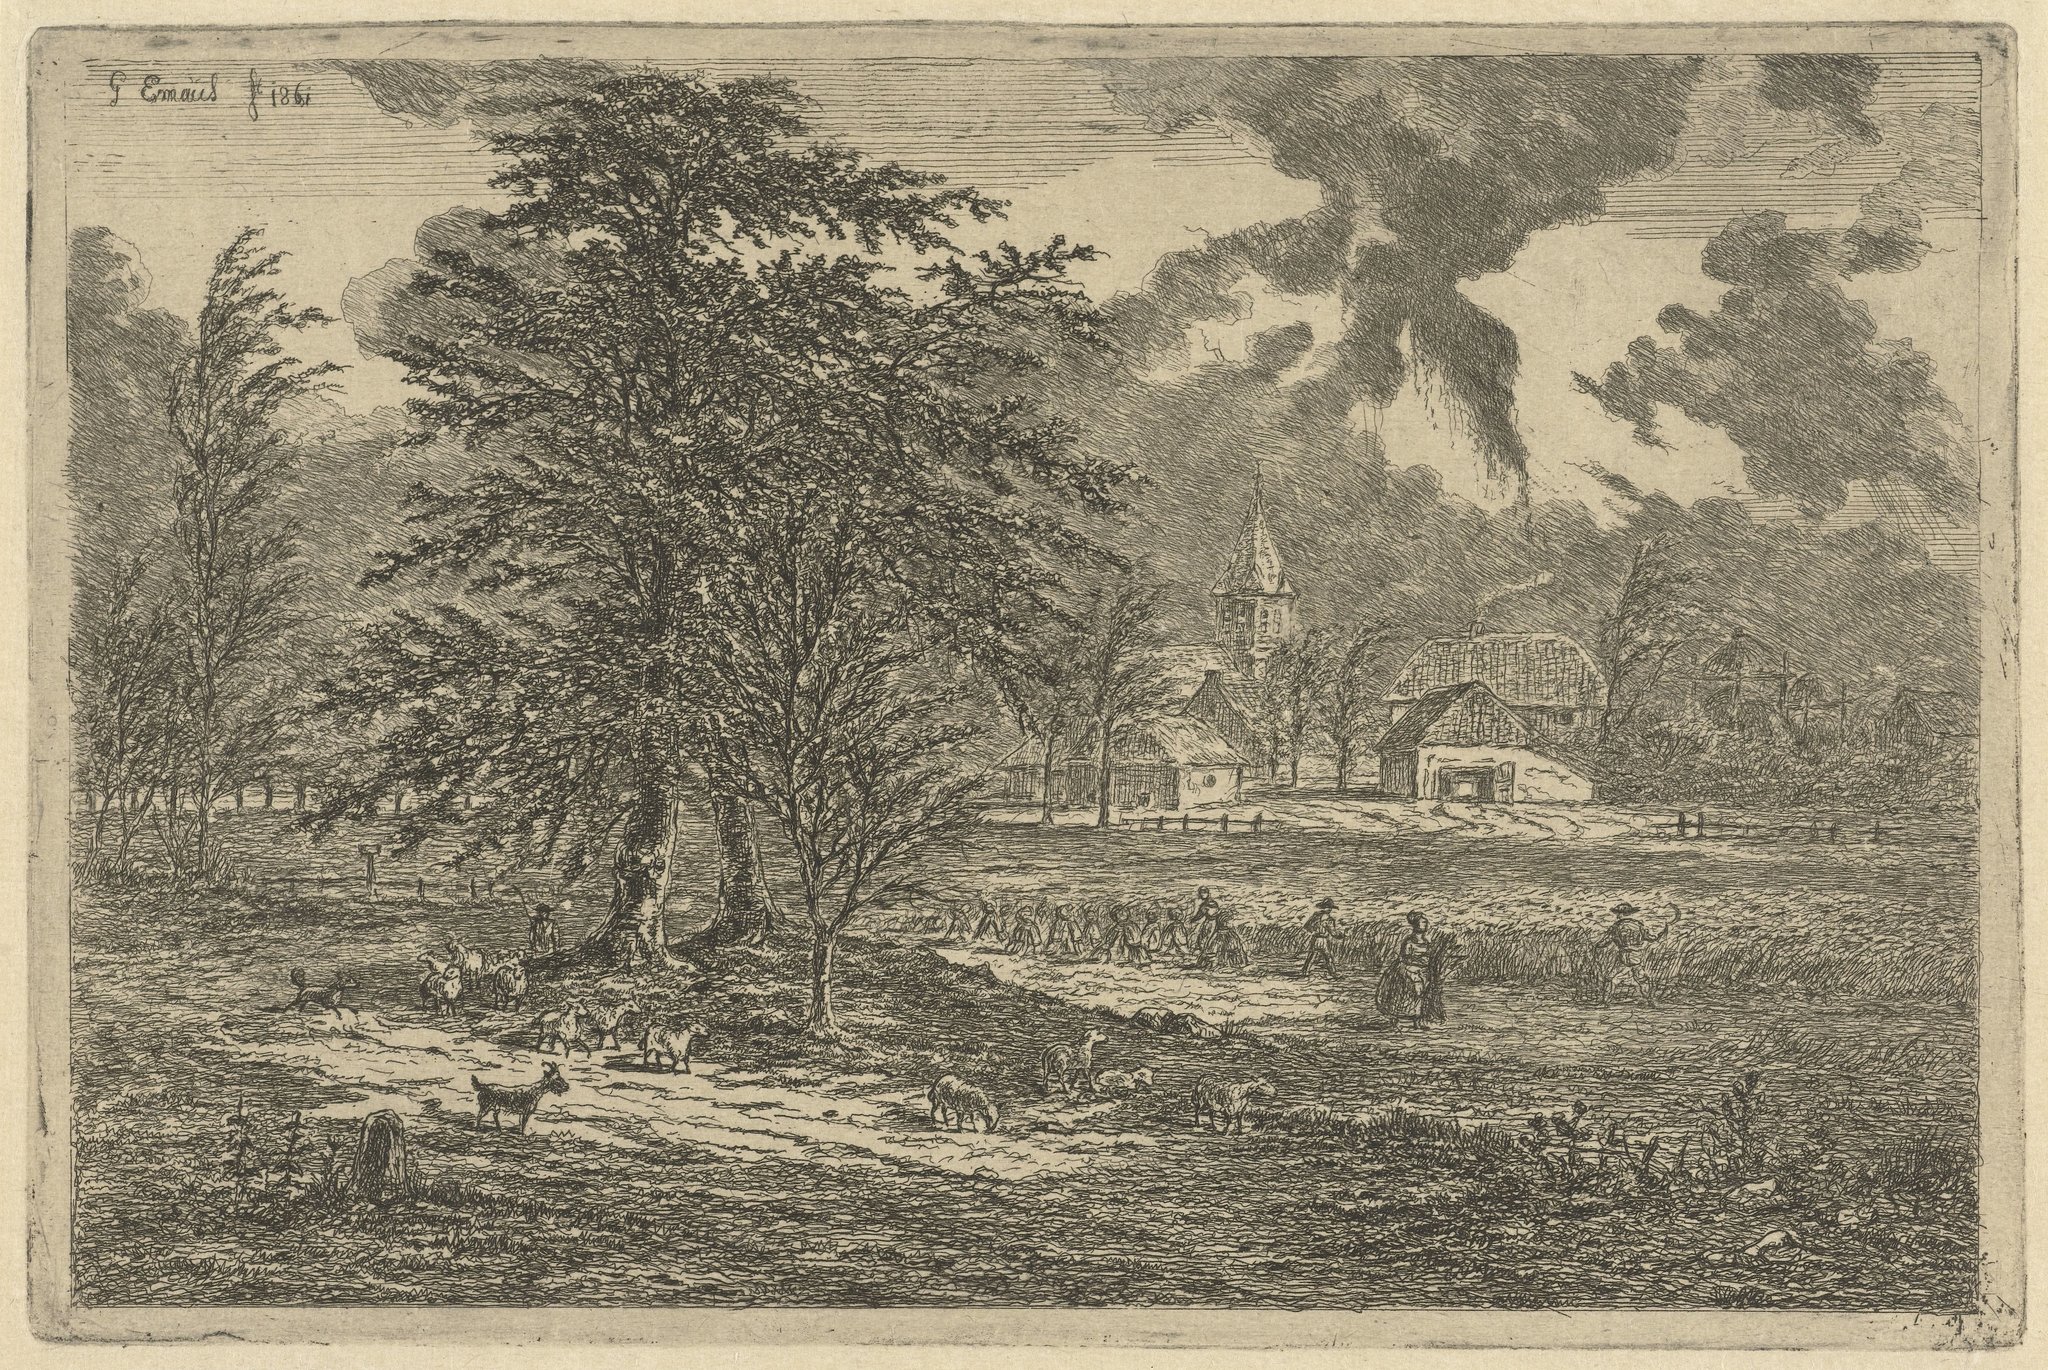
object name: print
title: Schaapsherder bij korenveld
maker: gerardus emaus de micault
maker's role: draughtsman, print maker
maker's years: 1798-1863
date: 1861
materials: paper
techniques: etching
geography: netherlands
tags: harvest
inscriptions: collector's mark: Lugt 2228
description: Een schaapsherder loopt met zijn kudde bij een boompartij, terwijl op de akker achter hem mensen koren aan het oogsten zijn. Boven het dorp op de achtergrond hangen donkere wolken.